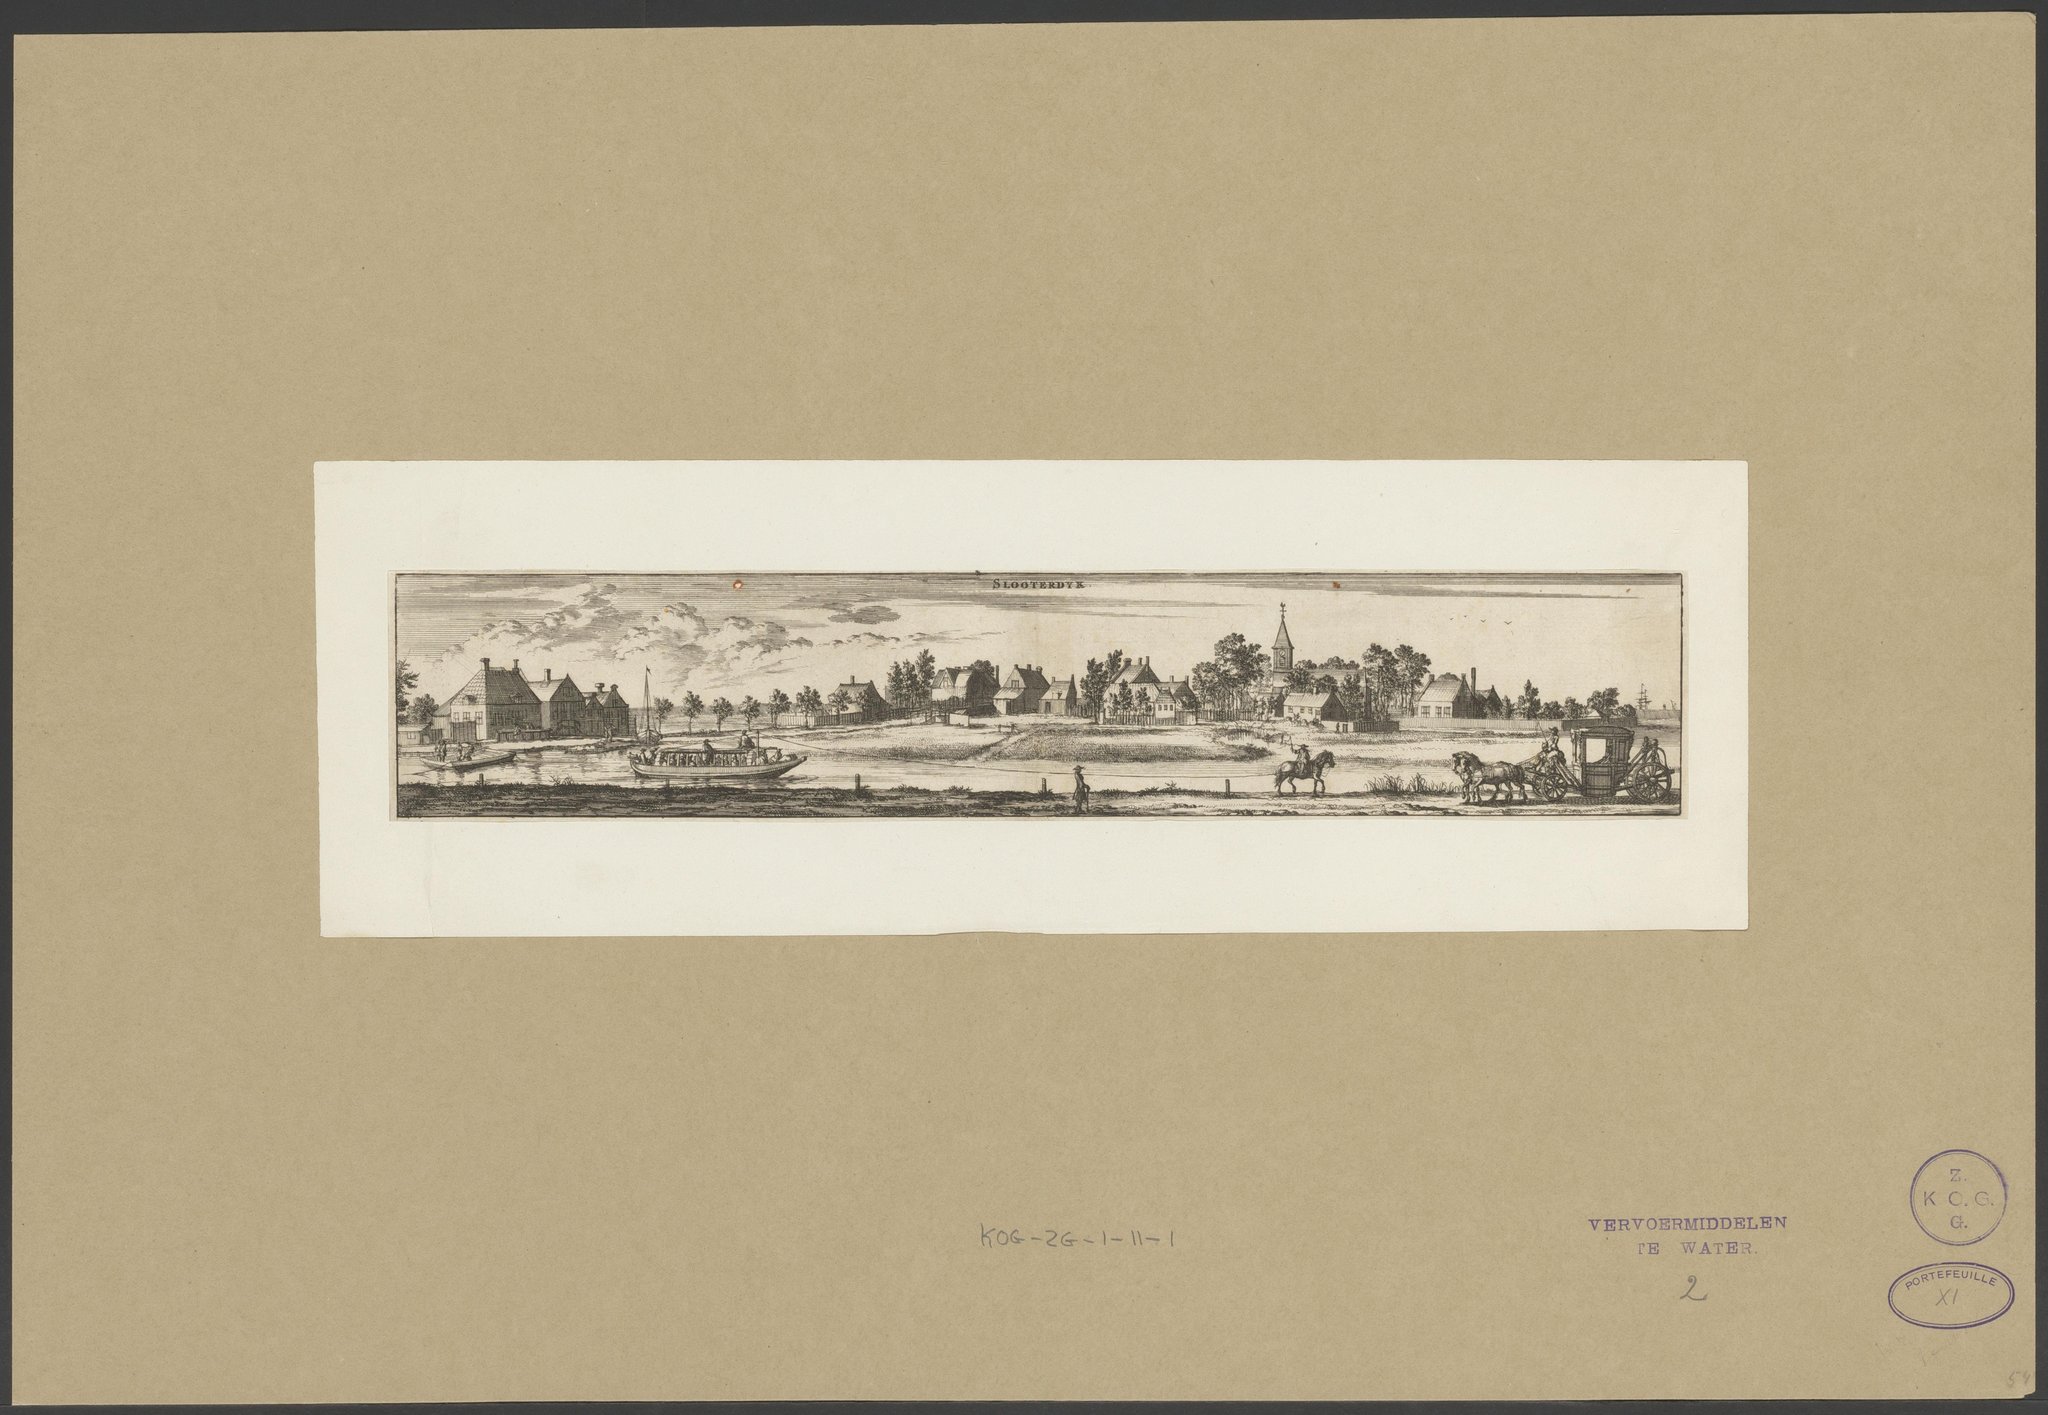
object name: print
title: Gezicht op Sloterdijk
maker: jan luyken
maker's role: draughtsman, print maker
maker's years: 1649-1712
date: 1693-1726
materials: paper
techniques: etching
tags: prospect of village, silhouette of village, sloterdijk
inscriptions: stamp, collector's mark: Lugt 1641, stamp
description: Gezicht op Sloterdijk met een trekschuit. Onderwerpsrubrieken binnen de Atlas Zeden en Gewoonten: Handel, nijverheid en verkeer, Vervoermiddelen te land en te water, Vervoermiddelen te water.